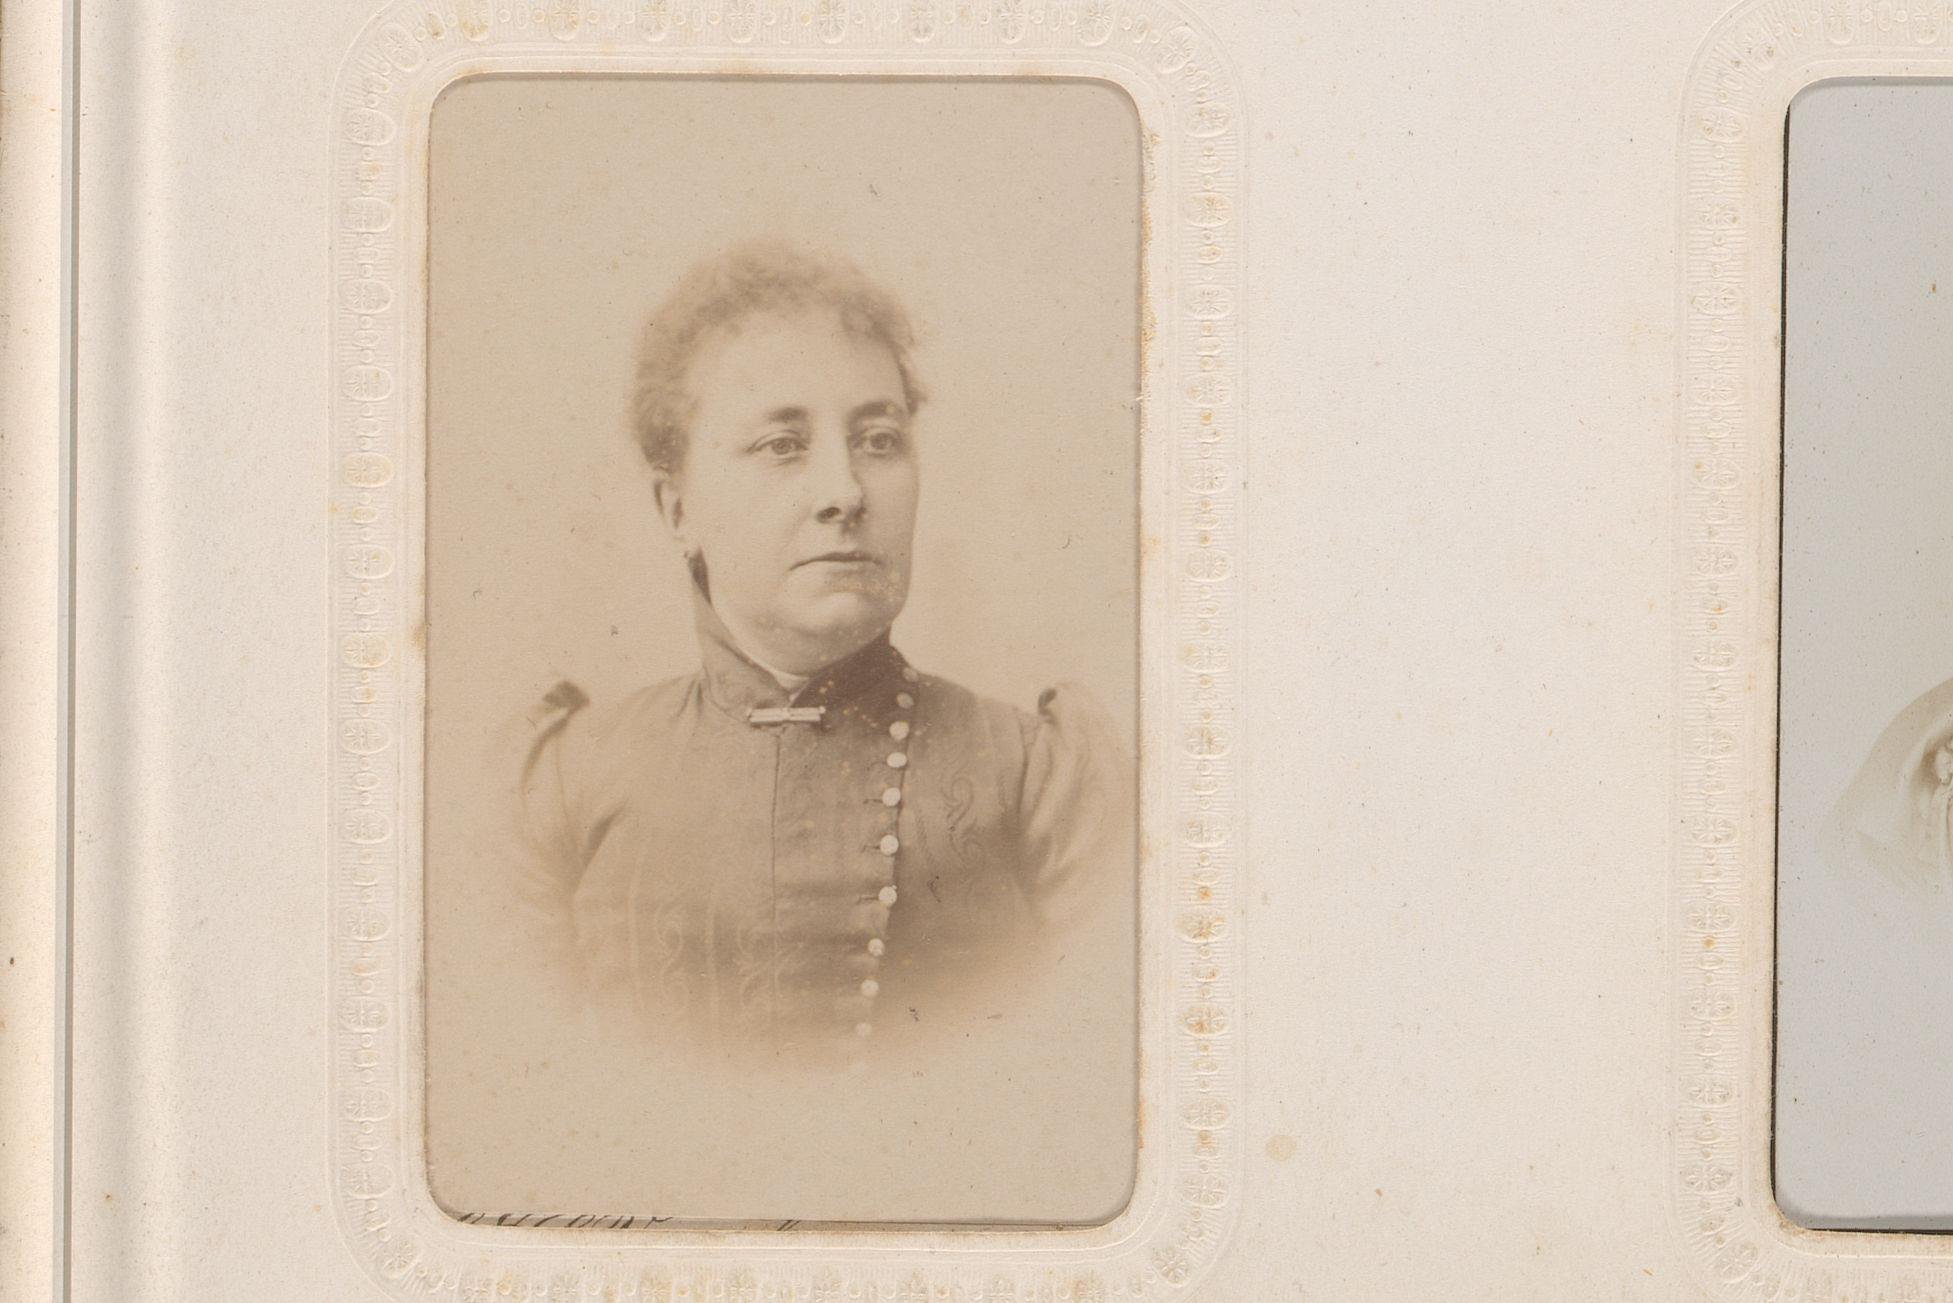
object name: photograph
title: Portret van een vrouw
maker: Anonymous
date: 1860-1900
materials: cardboard, photographic support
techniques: albumen print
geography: netherlands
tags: historical persons - bb - woman